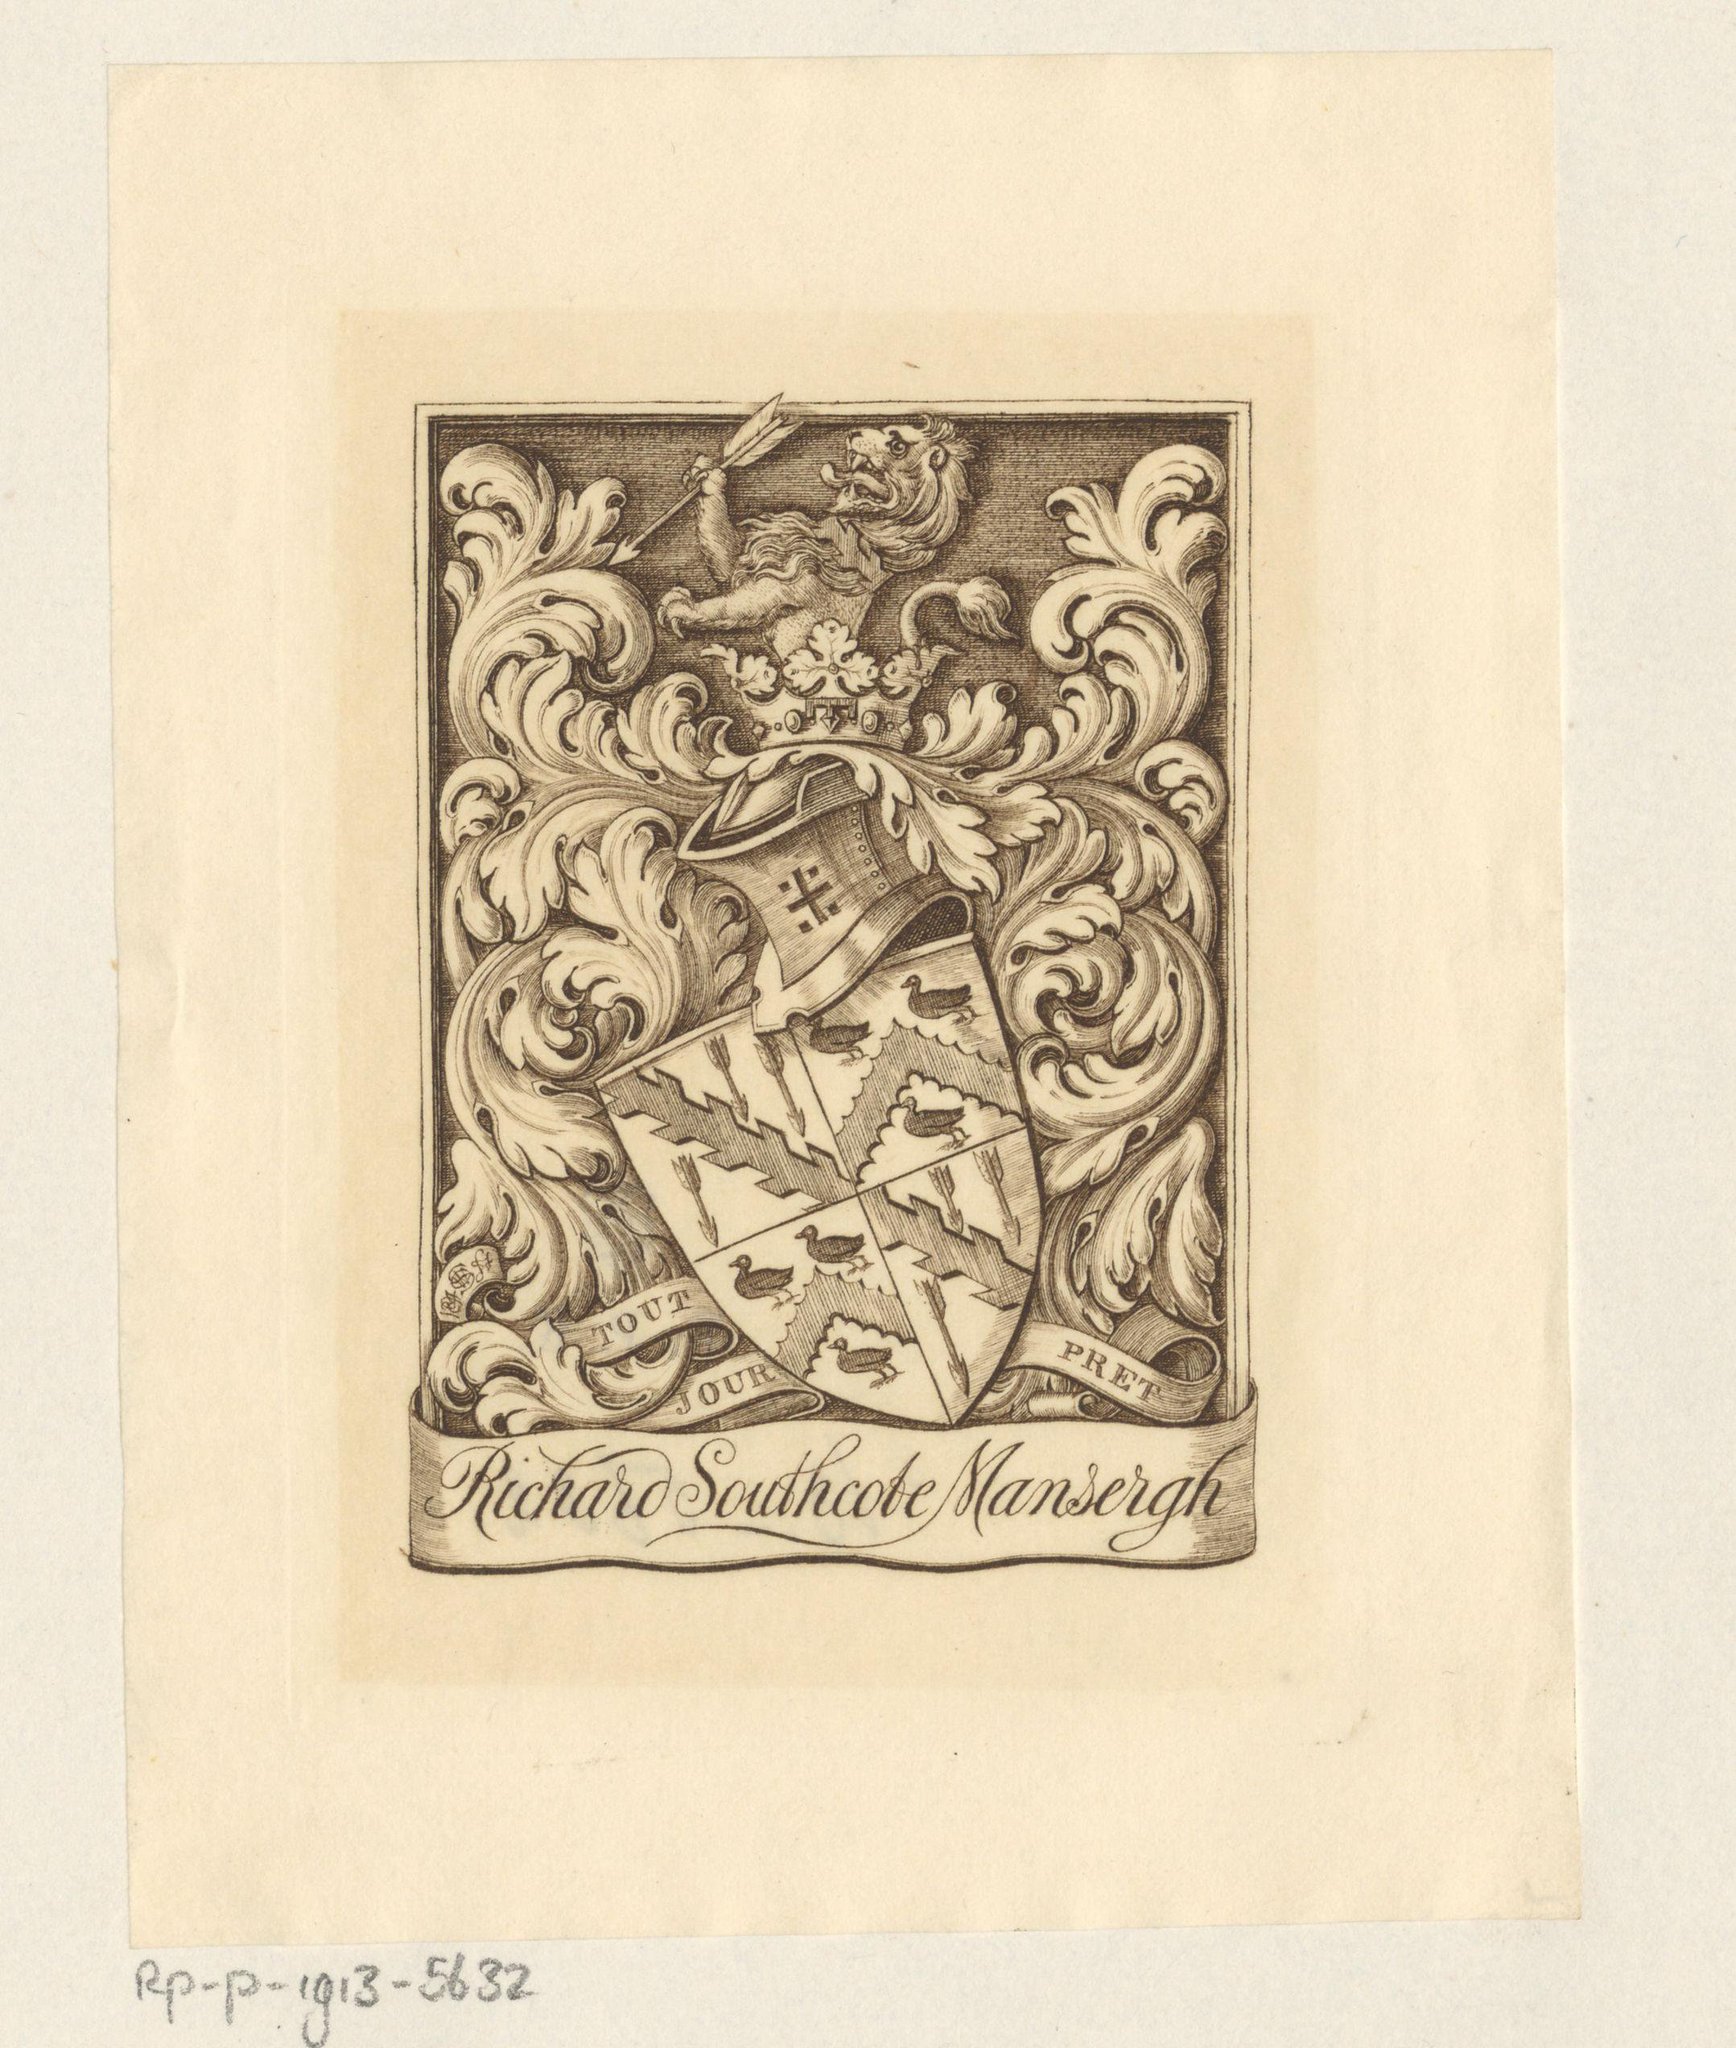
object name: bookplate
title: Ex libris van Richard Southcote Mansergh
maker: charles william sherborn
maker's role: print maker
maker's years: 1831-1912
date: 1894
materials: paper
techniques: engraving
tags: armorial bearing, heraldry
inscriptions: collector's mark: Lugt 2760, collector's mark: Lugt 2233